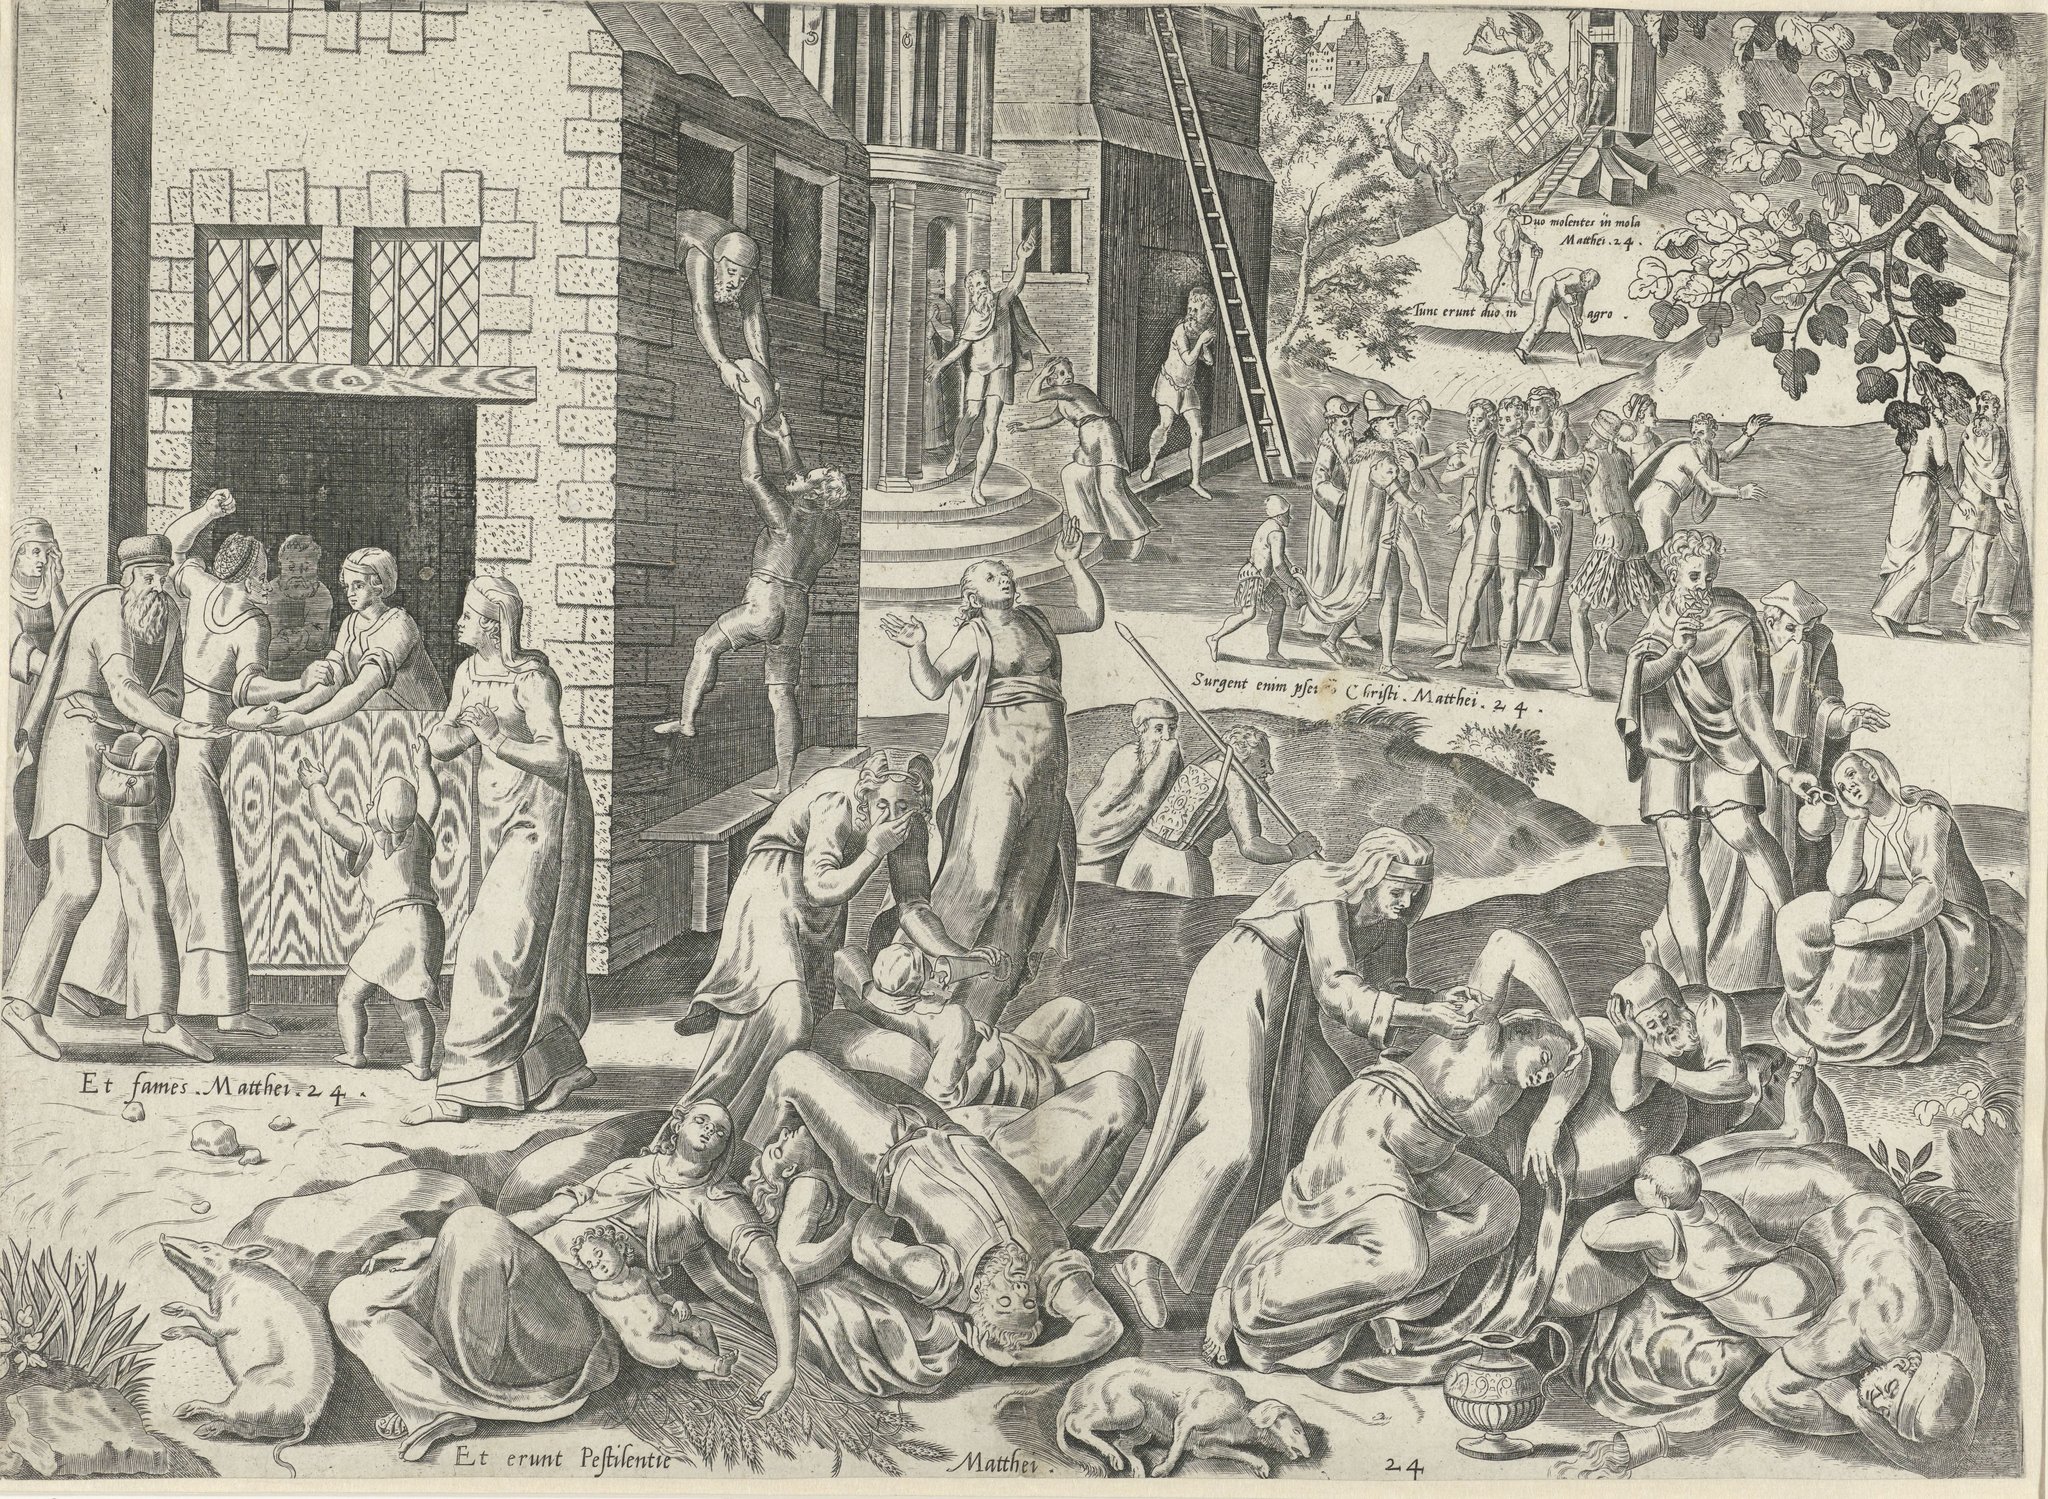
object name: print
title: Profetie van Christus over het einde der tijden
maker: frans hogenberg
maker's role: print maker, publisher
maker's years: 1538-1590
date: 1562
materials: paper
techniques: engraving, etching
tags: giving alms or other charity, e.g.: handing out food, plague, sayings of christ: discourse on the last things (matthew 24; mark 13; luke 21)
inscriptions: collector's mark: Lugt 2760, collector's mark: Lugt 2228, name: ‘Brugel’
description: De profetie van Christus over het einde der tijden (Matth. 24). Links krijgen de hongerigen brood uitgereikt. Op de voorgrond doden ten gevolge van de pest.